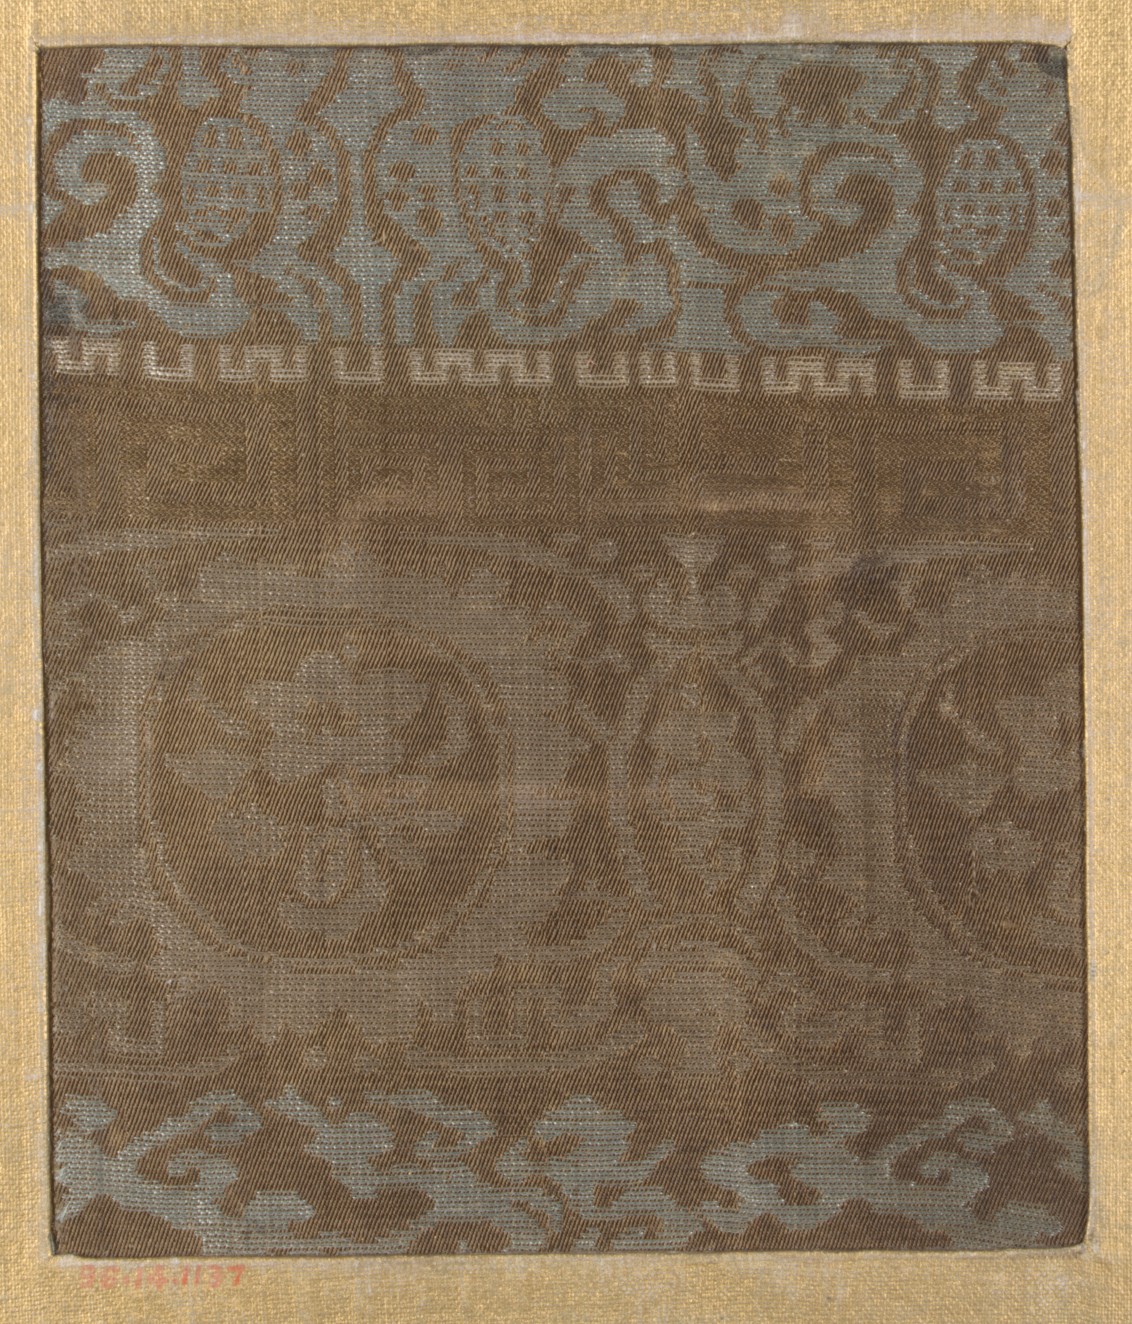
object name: piece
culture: japanese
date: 1701-1900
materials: silk